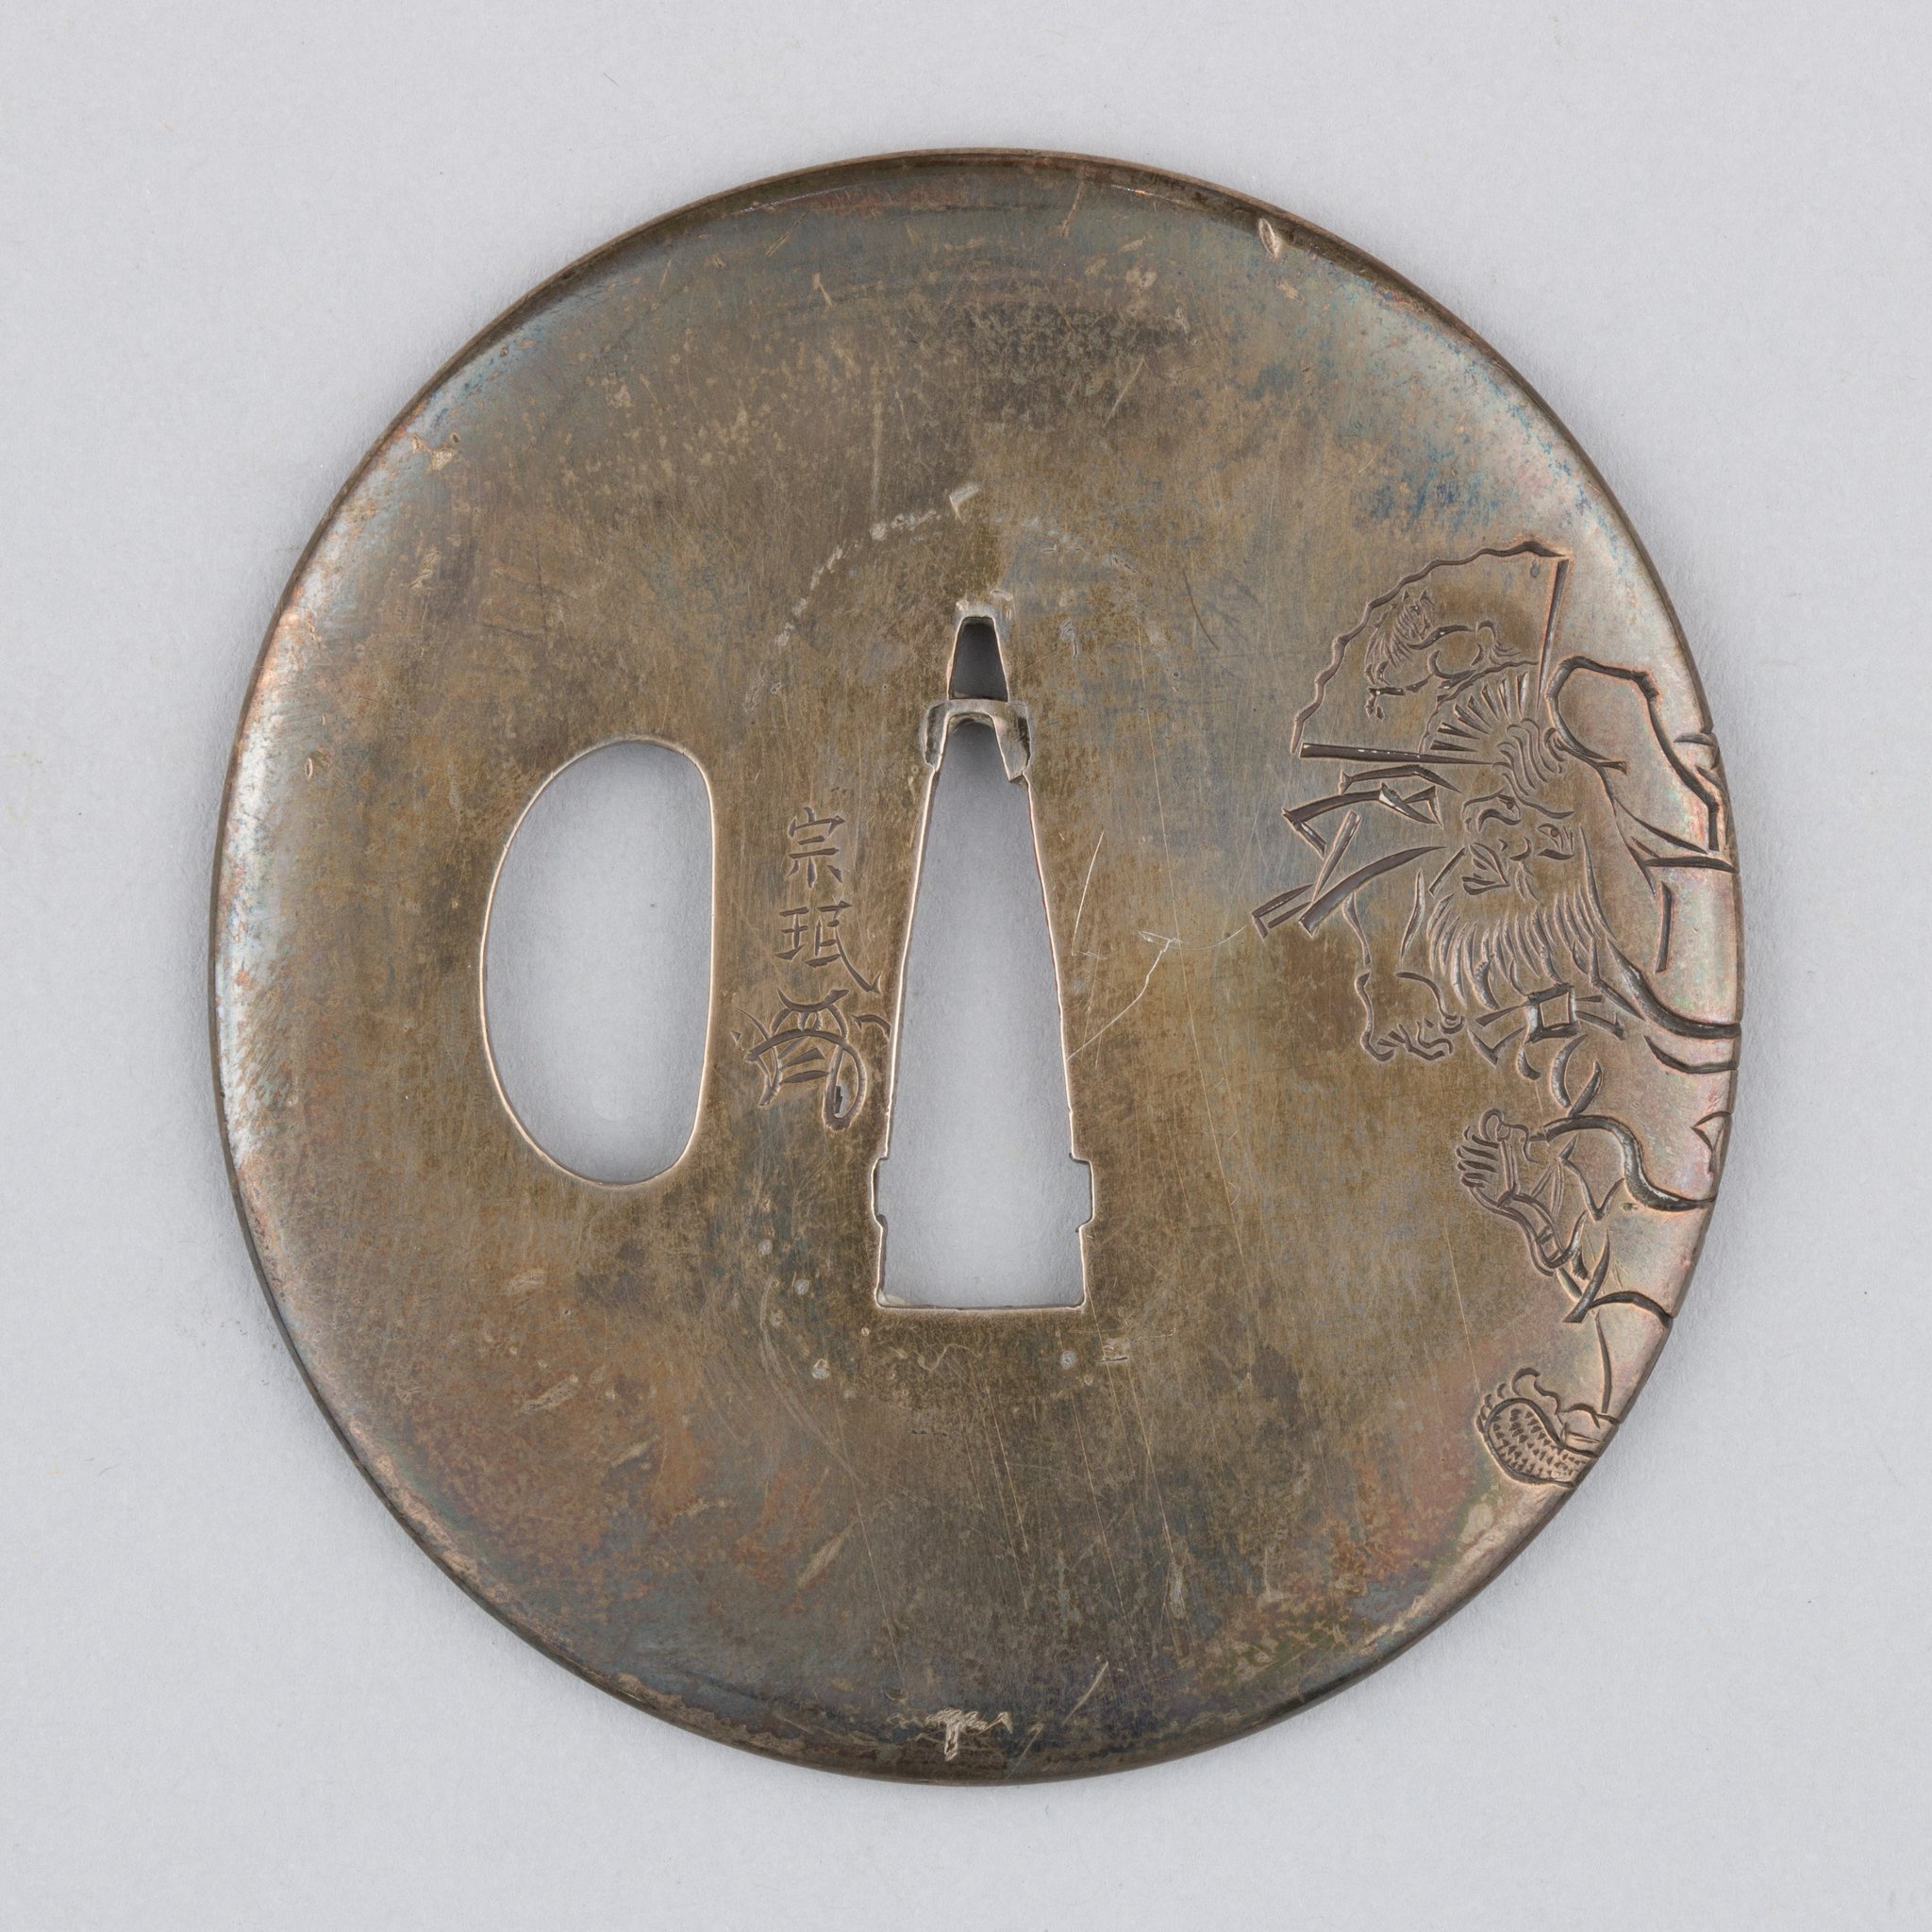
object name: sword guard tsuba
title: Sword Guard (Tsuba)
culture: japanese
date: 1701-1733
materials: copper, silver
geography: japan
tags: men